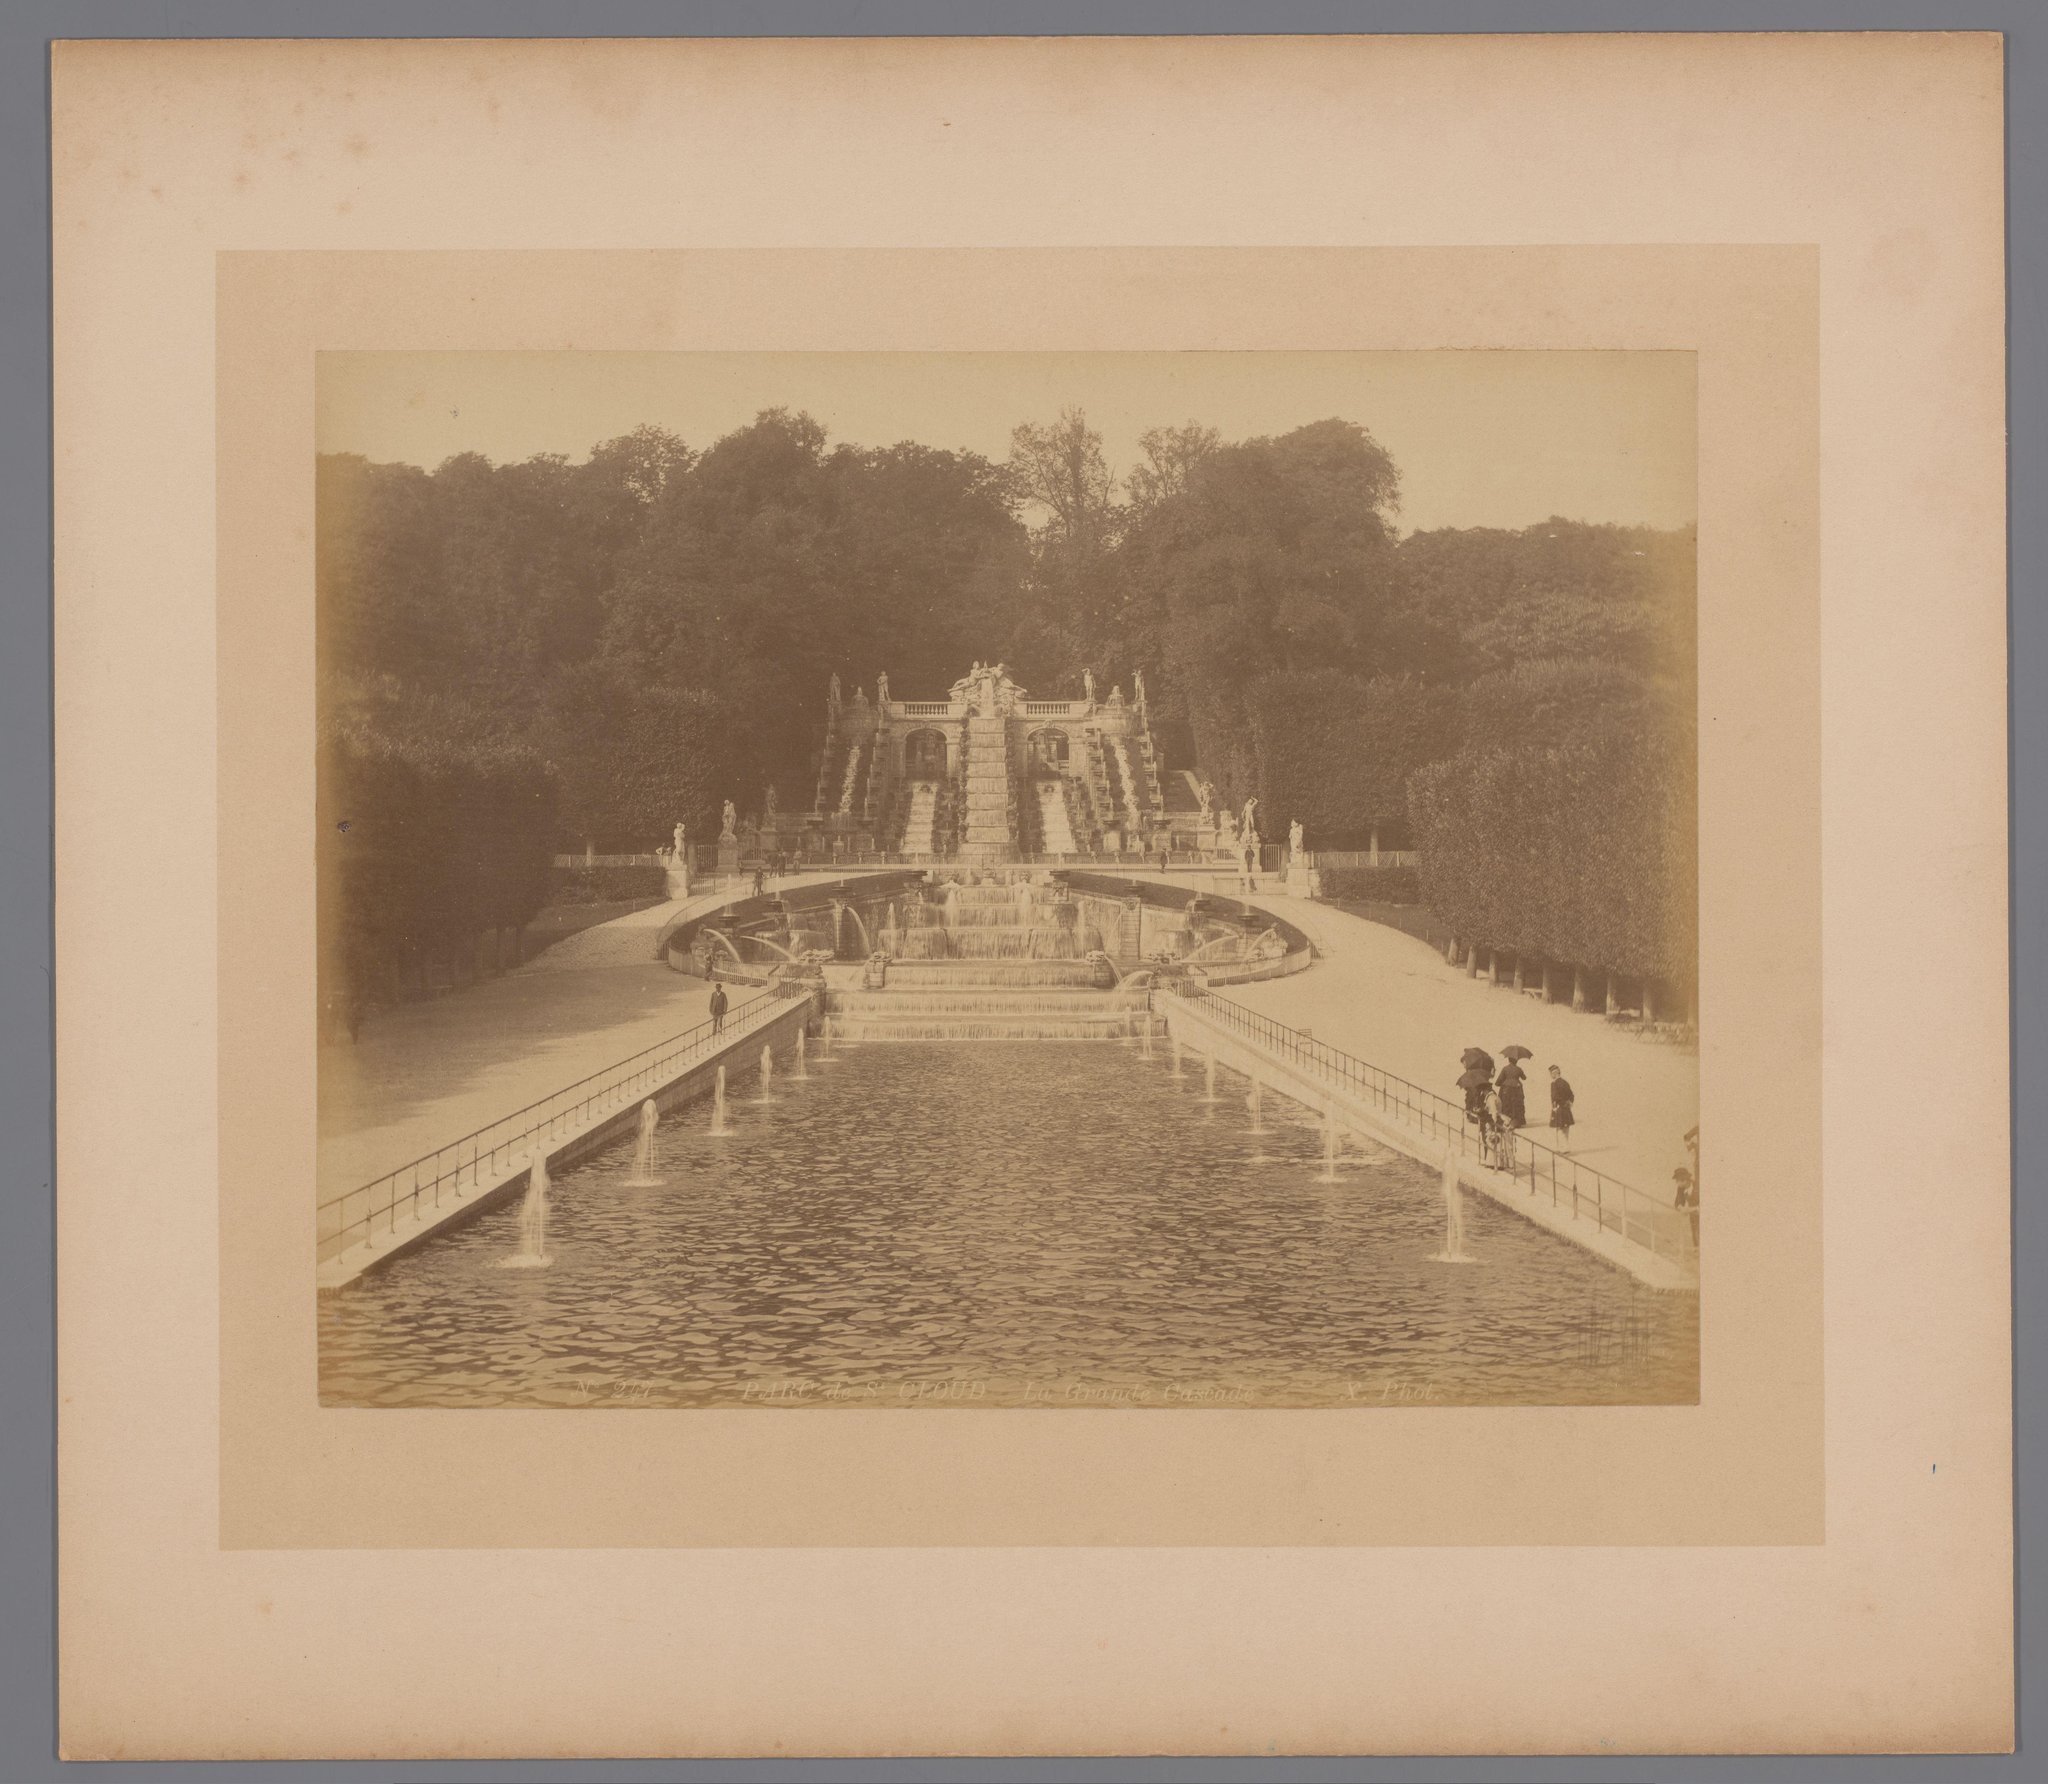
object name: photograph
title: "Parc de St. Cloud, La Grande Cascade", Parijs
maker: j. kühn (uitgever)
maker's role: publisher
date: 1880-1900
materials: cardboard, paper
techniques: albumen print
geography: paris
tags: paris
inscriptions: inscription: ‘No. 247 PARC de St. Cloud La Grande Cascade X. Phot.’, check stamp: ‘Photographic [?] Company//J.KUHN//PARIS//220 170174 220, RUE DE RIVOLI’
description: Gezicht op een lange symmetrisch aangelegde vijver met fonteinen en enkele mensen met paraplu/parasol [?], Parijs, Frankrijk